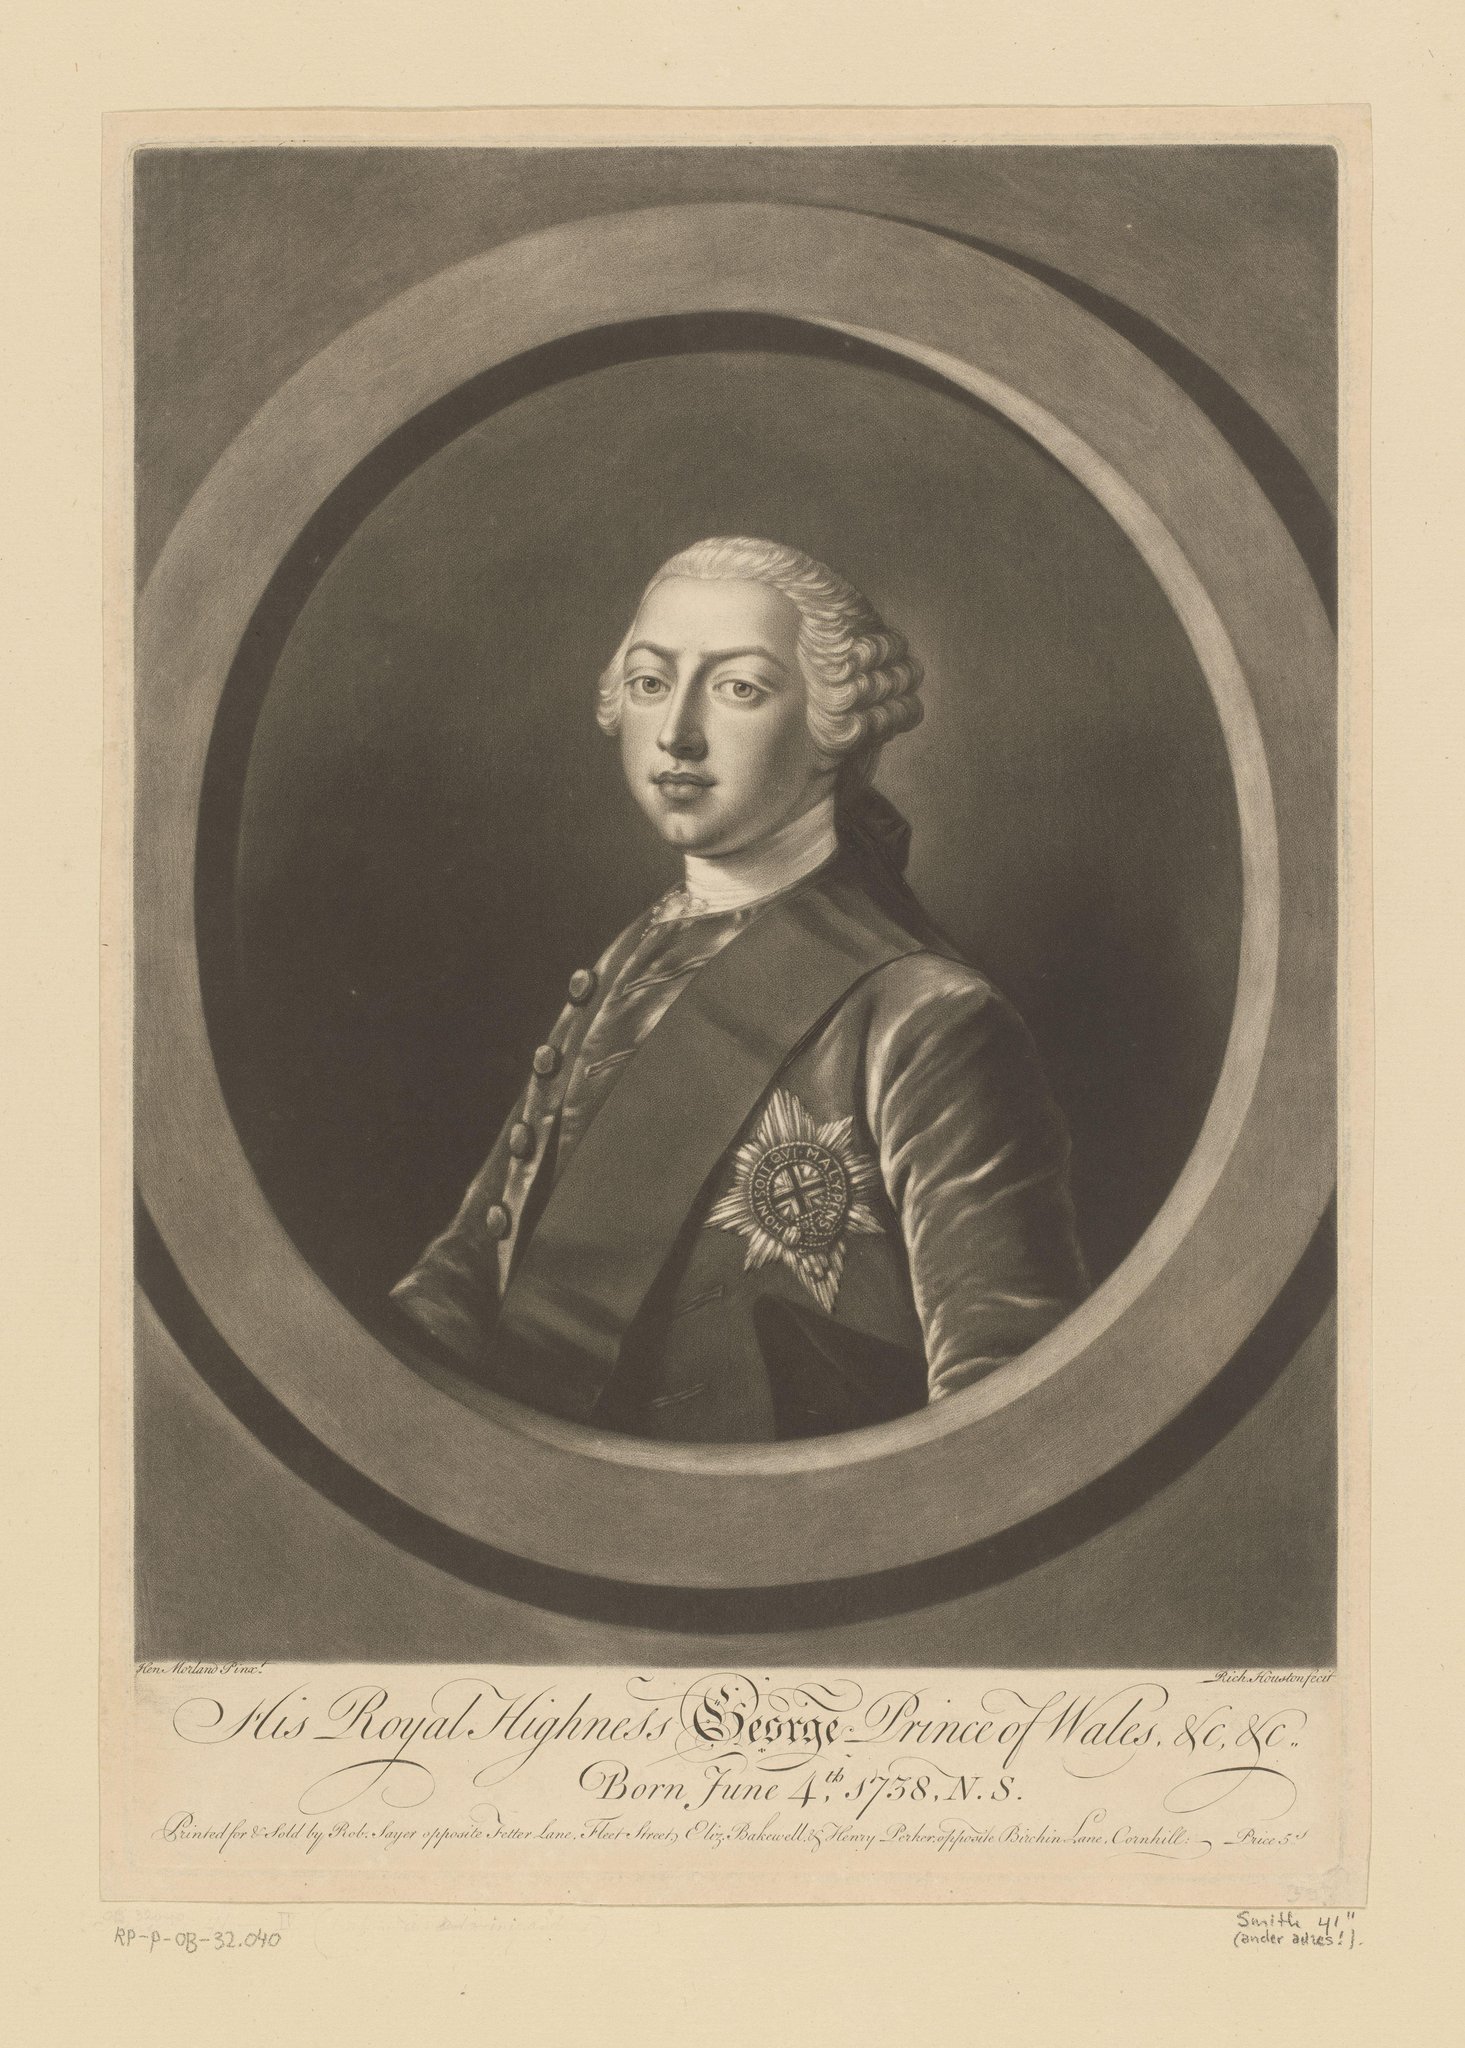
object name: print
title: Portret van George III, koning van het Verenigd Koninkrijk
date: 1745-1775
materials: paper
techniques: mezzotint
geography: london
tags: london, george iii (koning van het verenigd koninkrijk), historical persons, king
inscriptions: collector's mark: Lugt 240